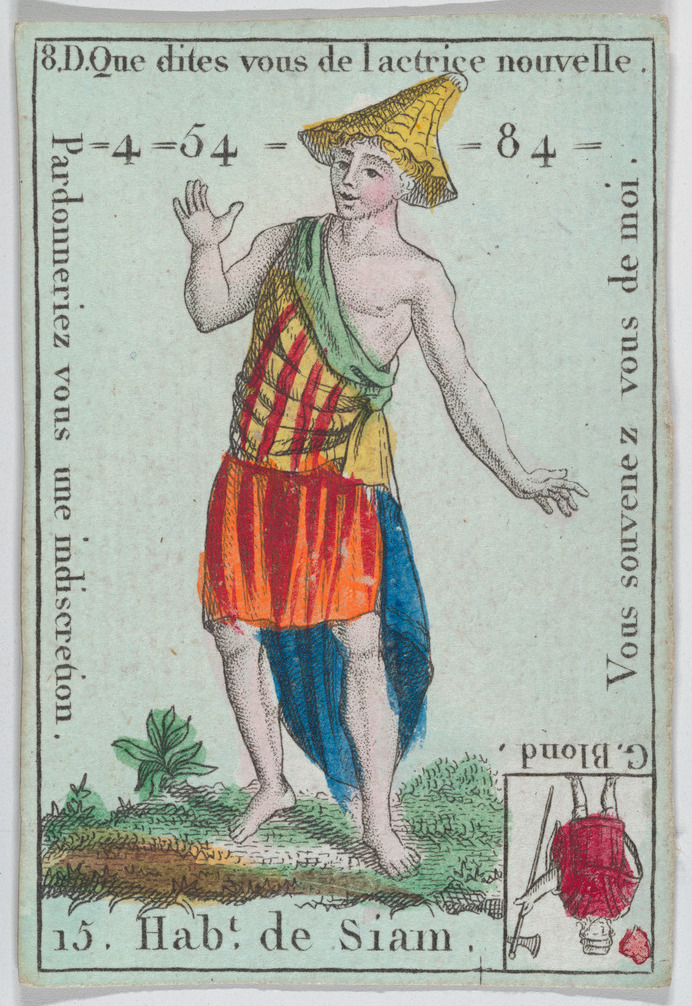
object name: print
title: Hab.t de Siam from playing cards "Jeu d'Or"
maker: anonymous, french, 18th century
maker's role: artist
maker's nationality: french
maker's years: 1700-1800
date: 1700-1799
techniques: etching, hand coloring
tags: men,portraits,playing cards